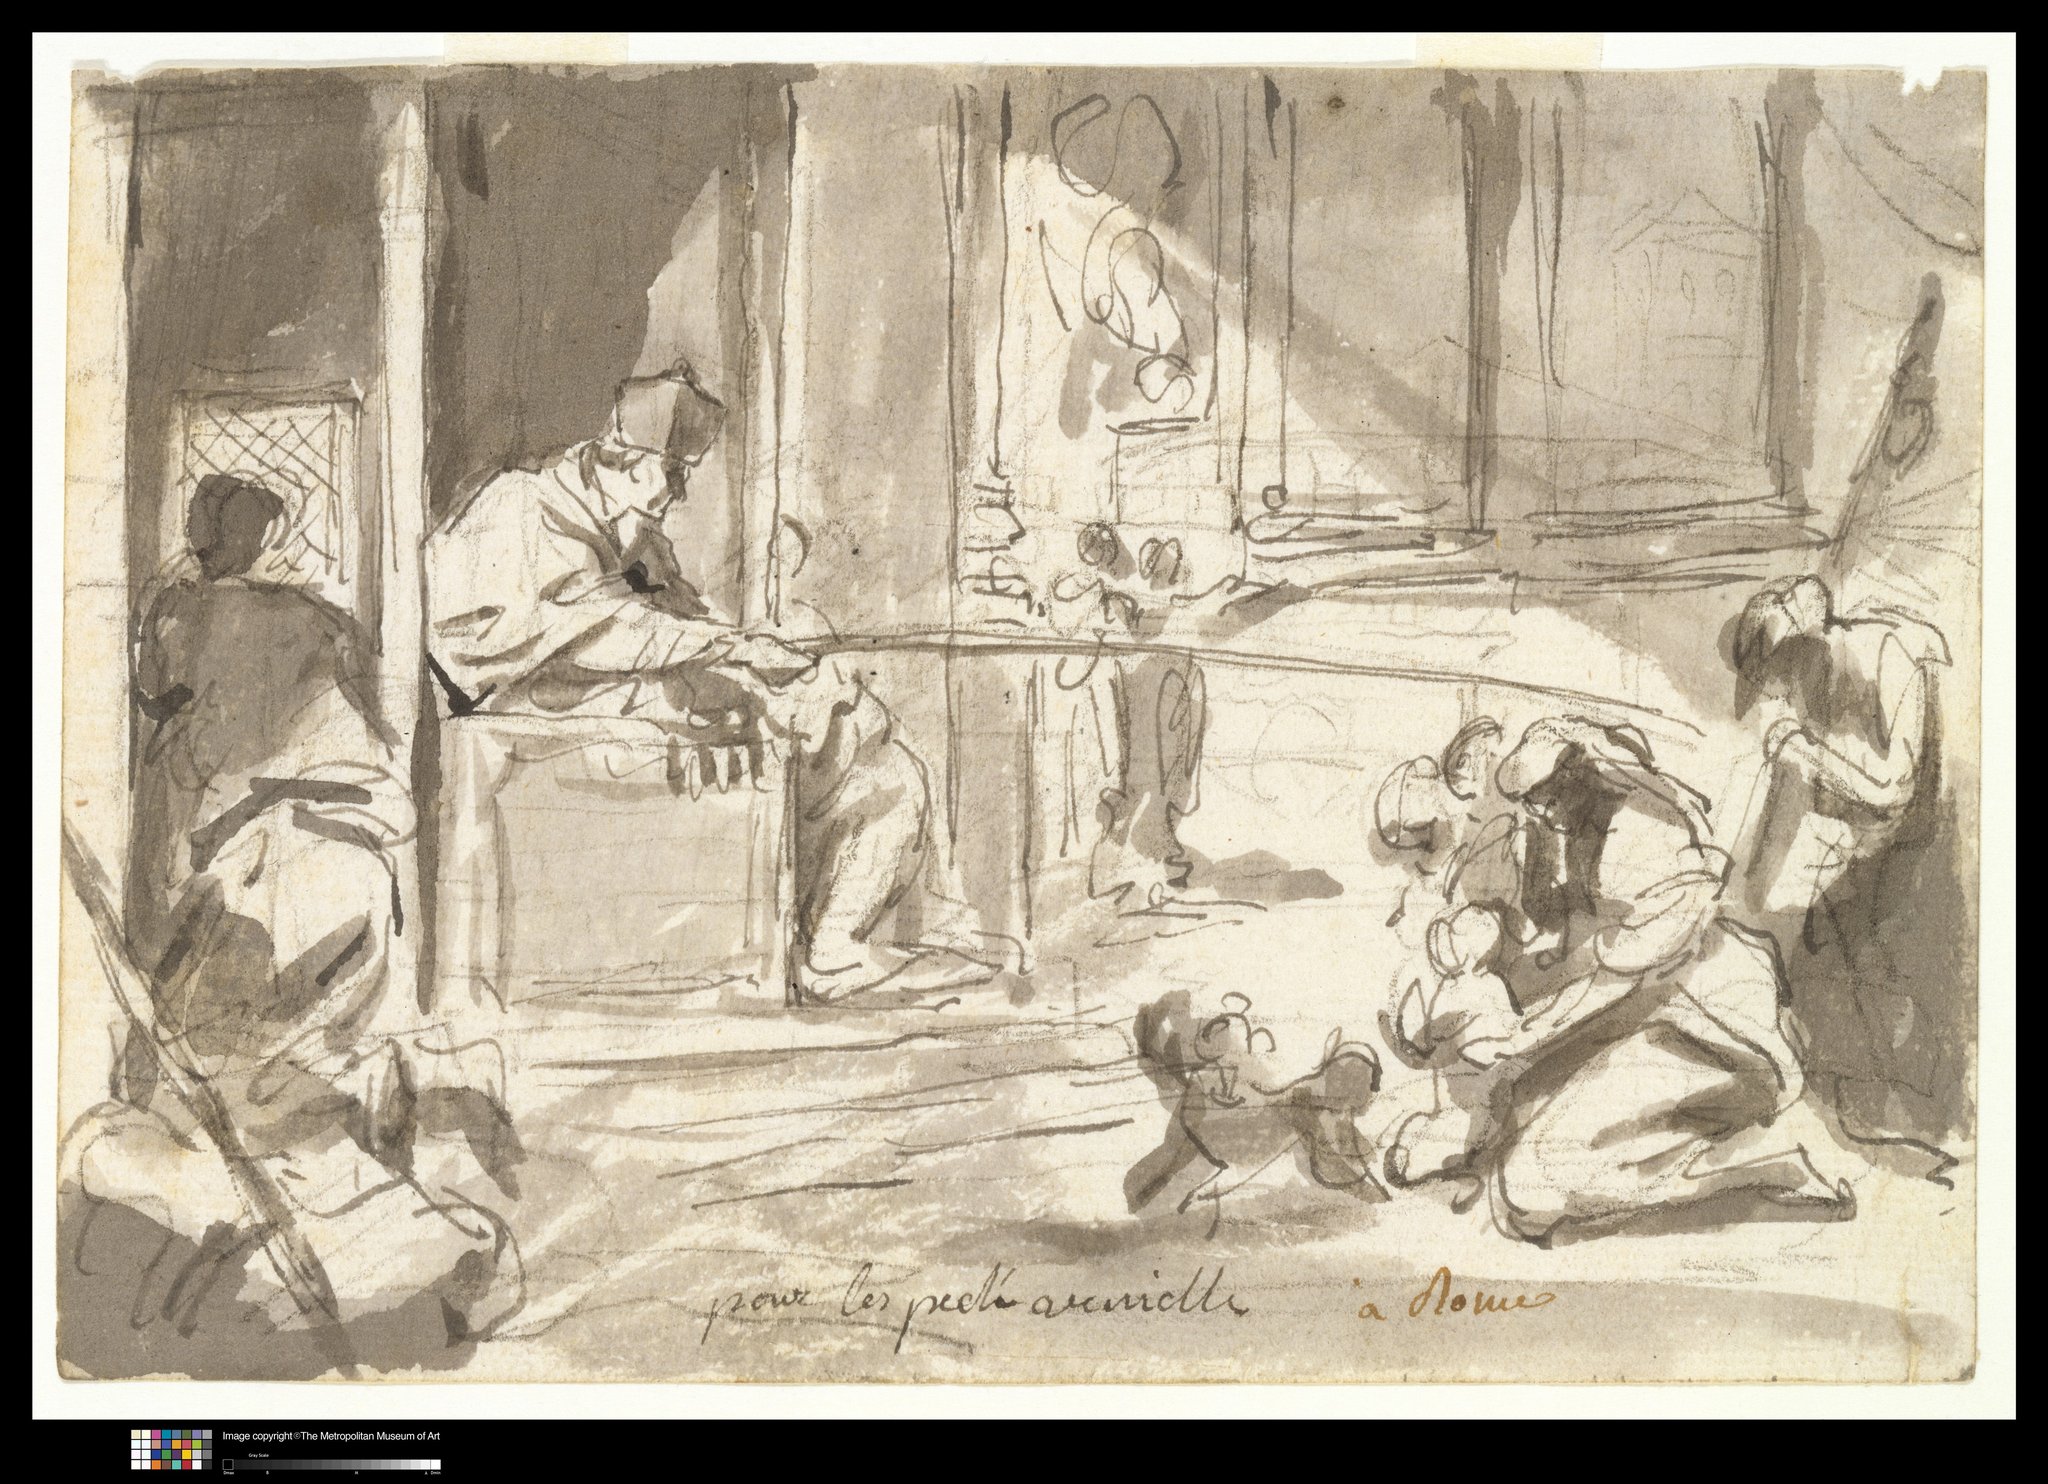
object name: drawing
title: Le Grand Pénitencier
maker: augustin pajou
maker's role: artist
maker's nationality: french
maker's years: 1730-1809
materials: chalk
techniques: pen, wash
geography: france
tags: prisons,men,women